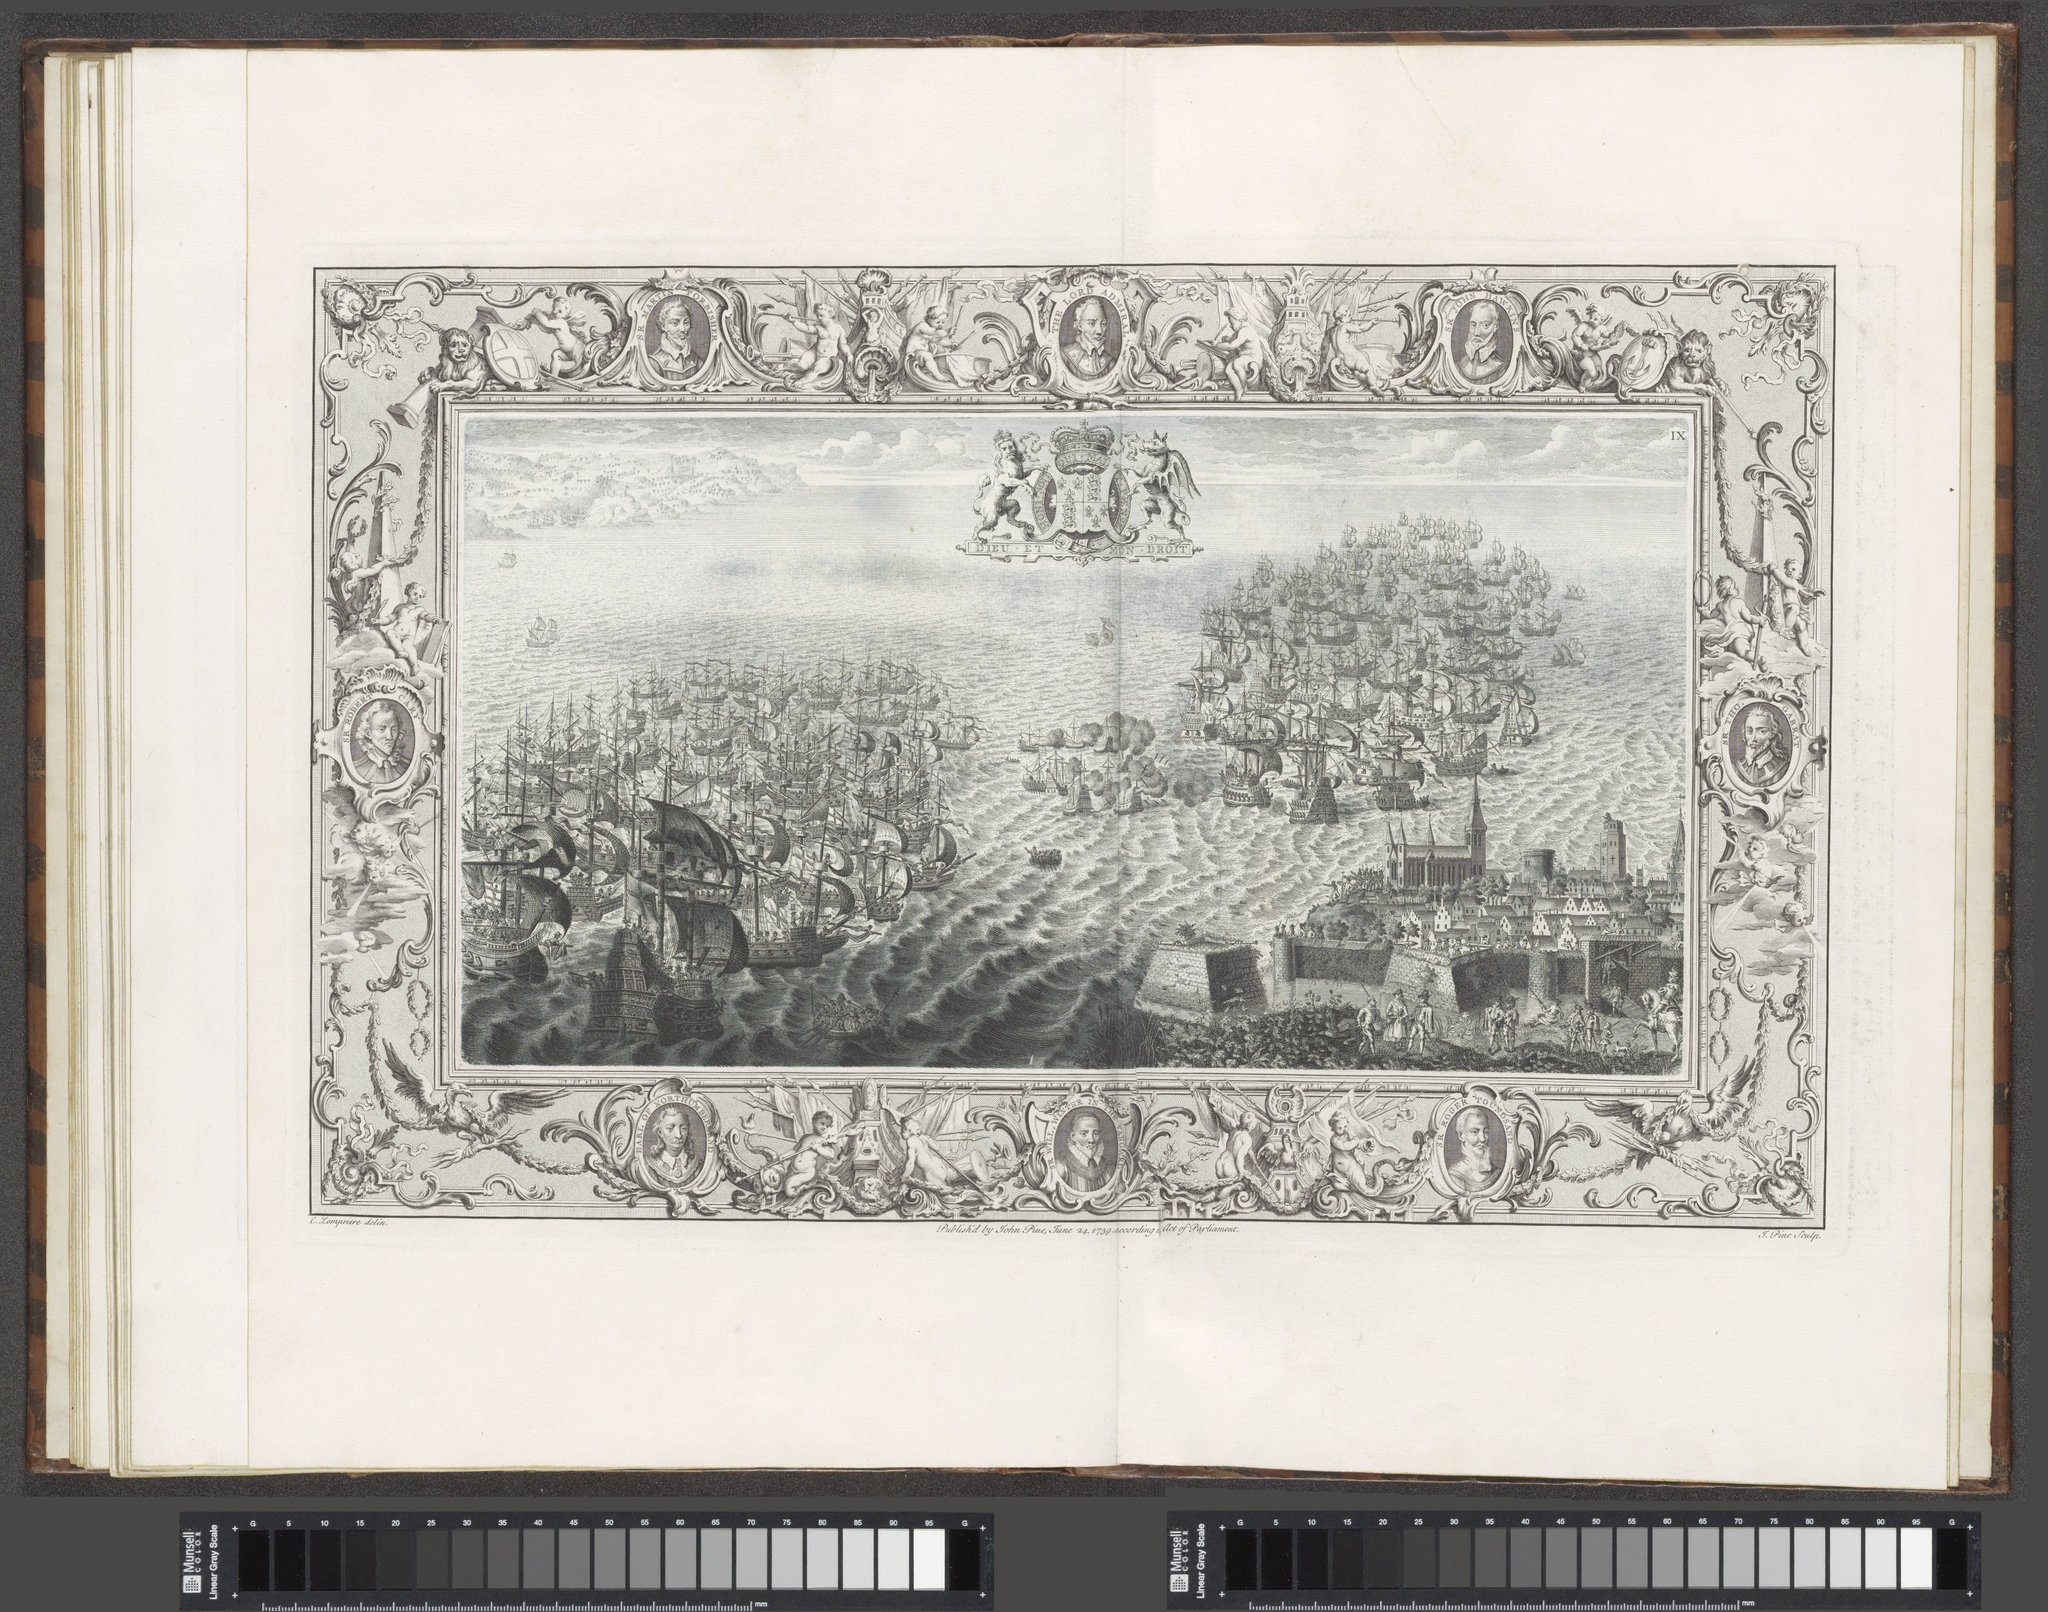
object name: album leaf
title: Reproductie van een wandtapijt over de Spaanse Armada (28-29 juli)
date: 1739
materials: paper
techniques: engraving, etching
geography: london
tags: plymouth, coat of arms (as symbol of the state, etc.), obelisk, needle, wind as a human face, blowing with rounded cheeks, battle (+ naval force), parts of ship's exterior: bow, tapestry, cupids: 'amores', 'amoretti', 'putti', armorial bearing, heraldry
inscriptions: date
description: Engelse en Spaanse vloot in Het Kanaal tussen Dover en Calais, met bovenaan het wapen van de Engelse koningin Elizabeth I. De voorstelling (genummerd IX) is gevat in een ornamentrand met acht portretten van bevelhebbers van de Engelse vloot. Midden boven het portret van Charles Howard, Lord High Admiral en opperbevelhebber van de Engelse vloot tegen de Spaanse Armada. Boven en onder tussen de portretten scheepsboegen met speren en vaandels en geflankeerd door putti. Zij blazen op een bazuin of schelp, trommelen, schrijven etc. Links en rechts staan vier putti bij een triomf- of gedenkzuil. Twee putti versieren de zuil met guirlandes. Een derde putti schrijft de gebeurtenissen op een in boek; de vierde heeft een zwaard en ouroboros in de hand. De ouroboros is een slang die in zijn eigen staart bijt en is daarmee een symbool van de eeuwigheid. Verder twee adelaars met bliksemschichten, de vier winden en twee leeuwen met zuil of drietand en een wapenschild. De rechter toont het Anker van Hoop, het wapen van de Engelse Admiraliteit. De voorstelling maakt deel uit van een boek over de Spaanse Armada en de tapijten die daarover in opdracht van Charles Howard werden gemaakt.